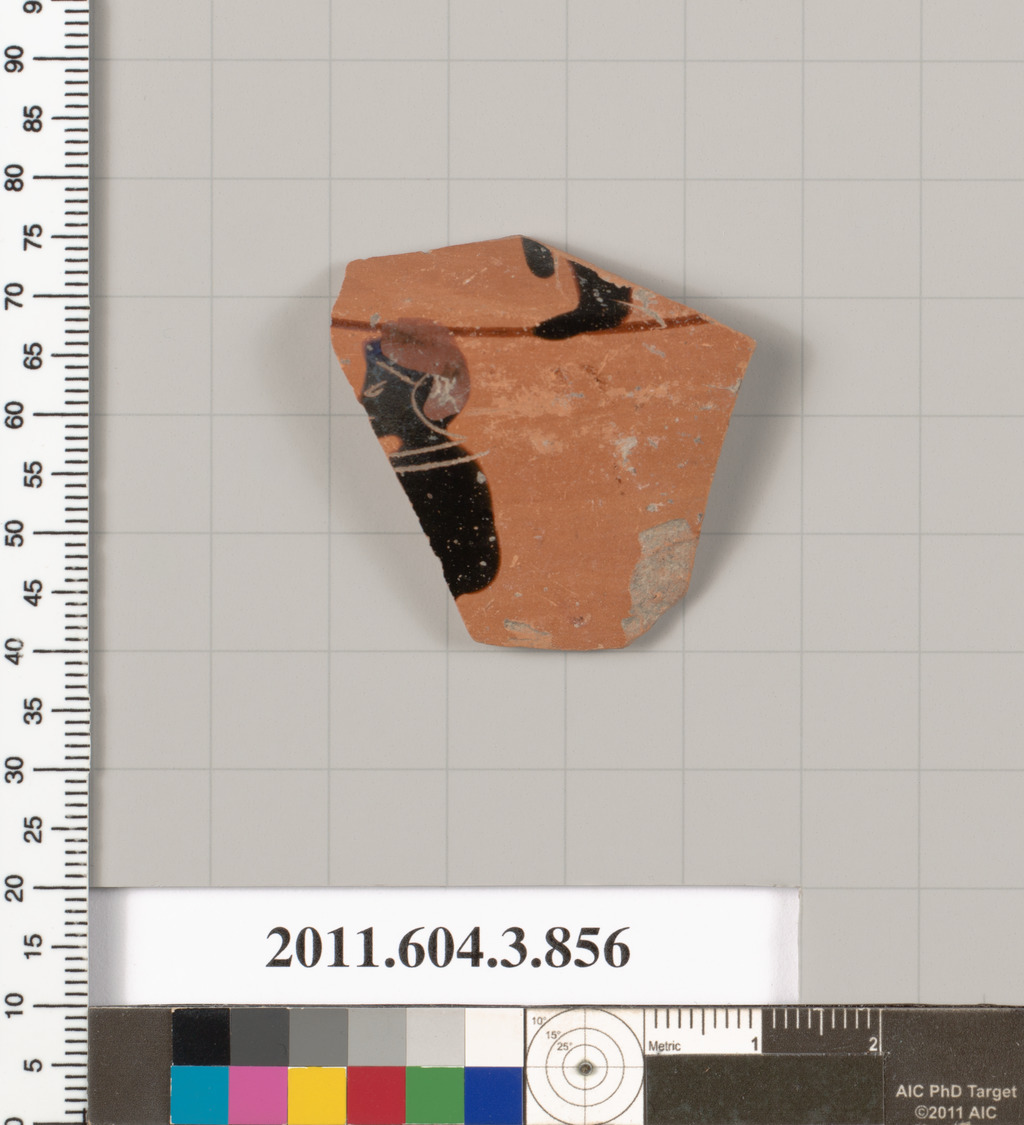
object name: lekythos fragment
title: Terracotta fragment of a lekythos (oil flask)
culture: greek, attic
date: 550-526 BCE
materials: terracotta